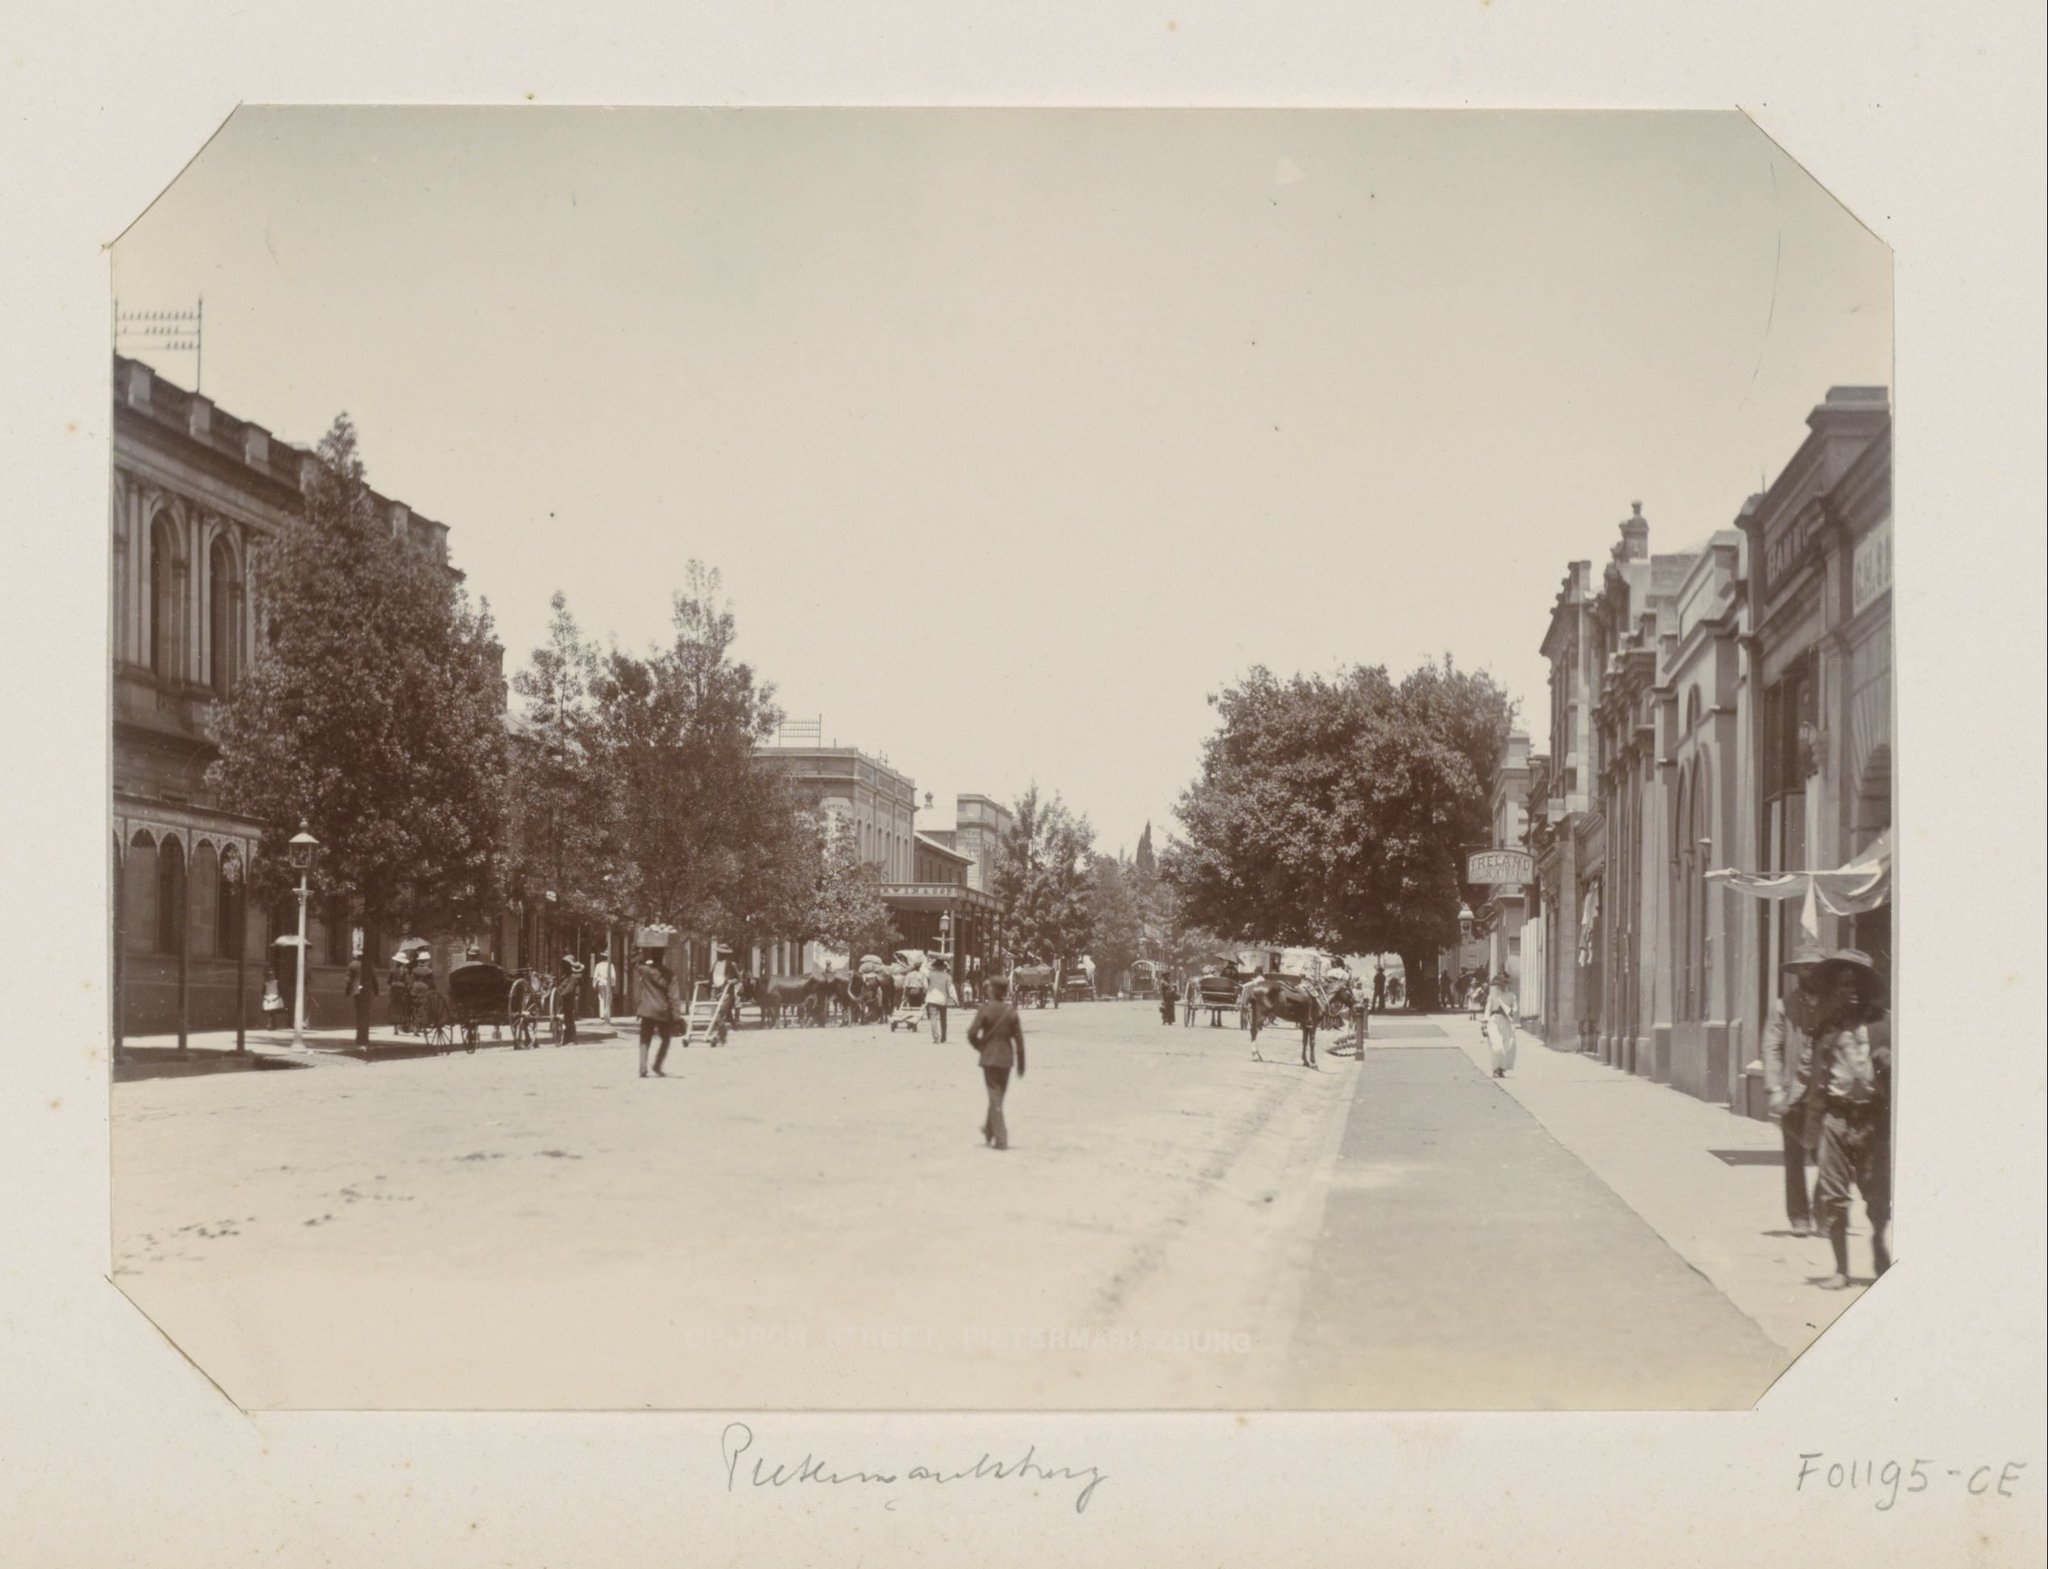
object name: photograph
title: Voorbijgangers, paarden en koetsen in Church Street te Pietermaritzburg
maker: Anonymous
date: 1880-1910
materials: cardboard, paper, photographic support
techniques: gelatin silver print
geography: pietermaritzburg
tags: street (+ city(-scape) with figures, staffage)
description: Onderdeel van Fotoalbum van een reis door de Verenigde Staten, Honolulu, Nederlands-Indië, Aden, Zanzibar en Zuidelijk Afrika.